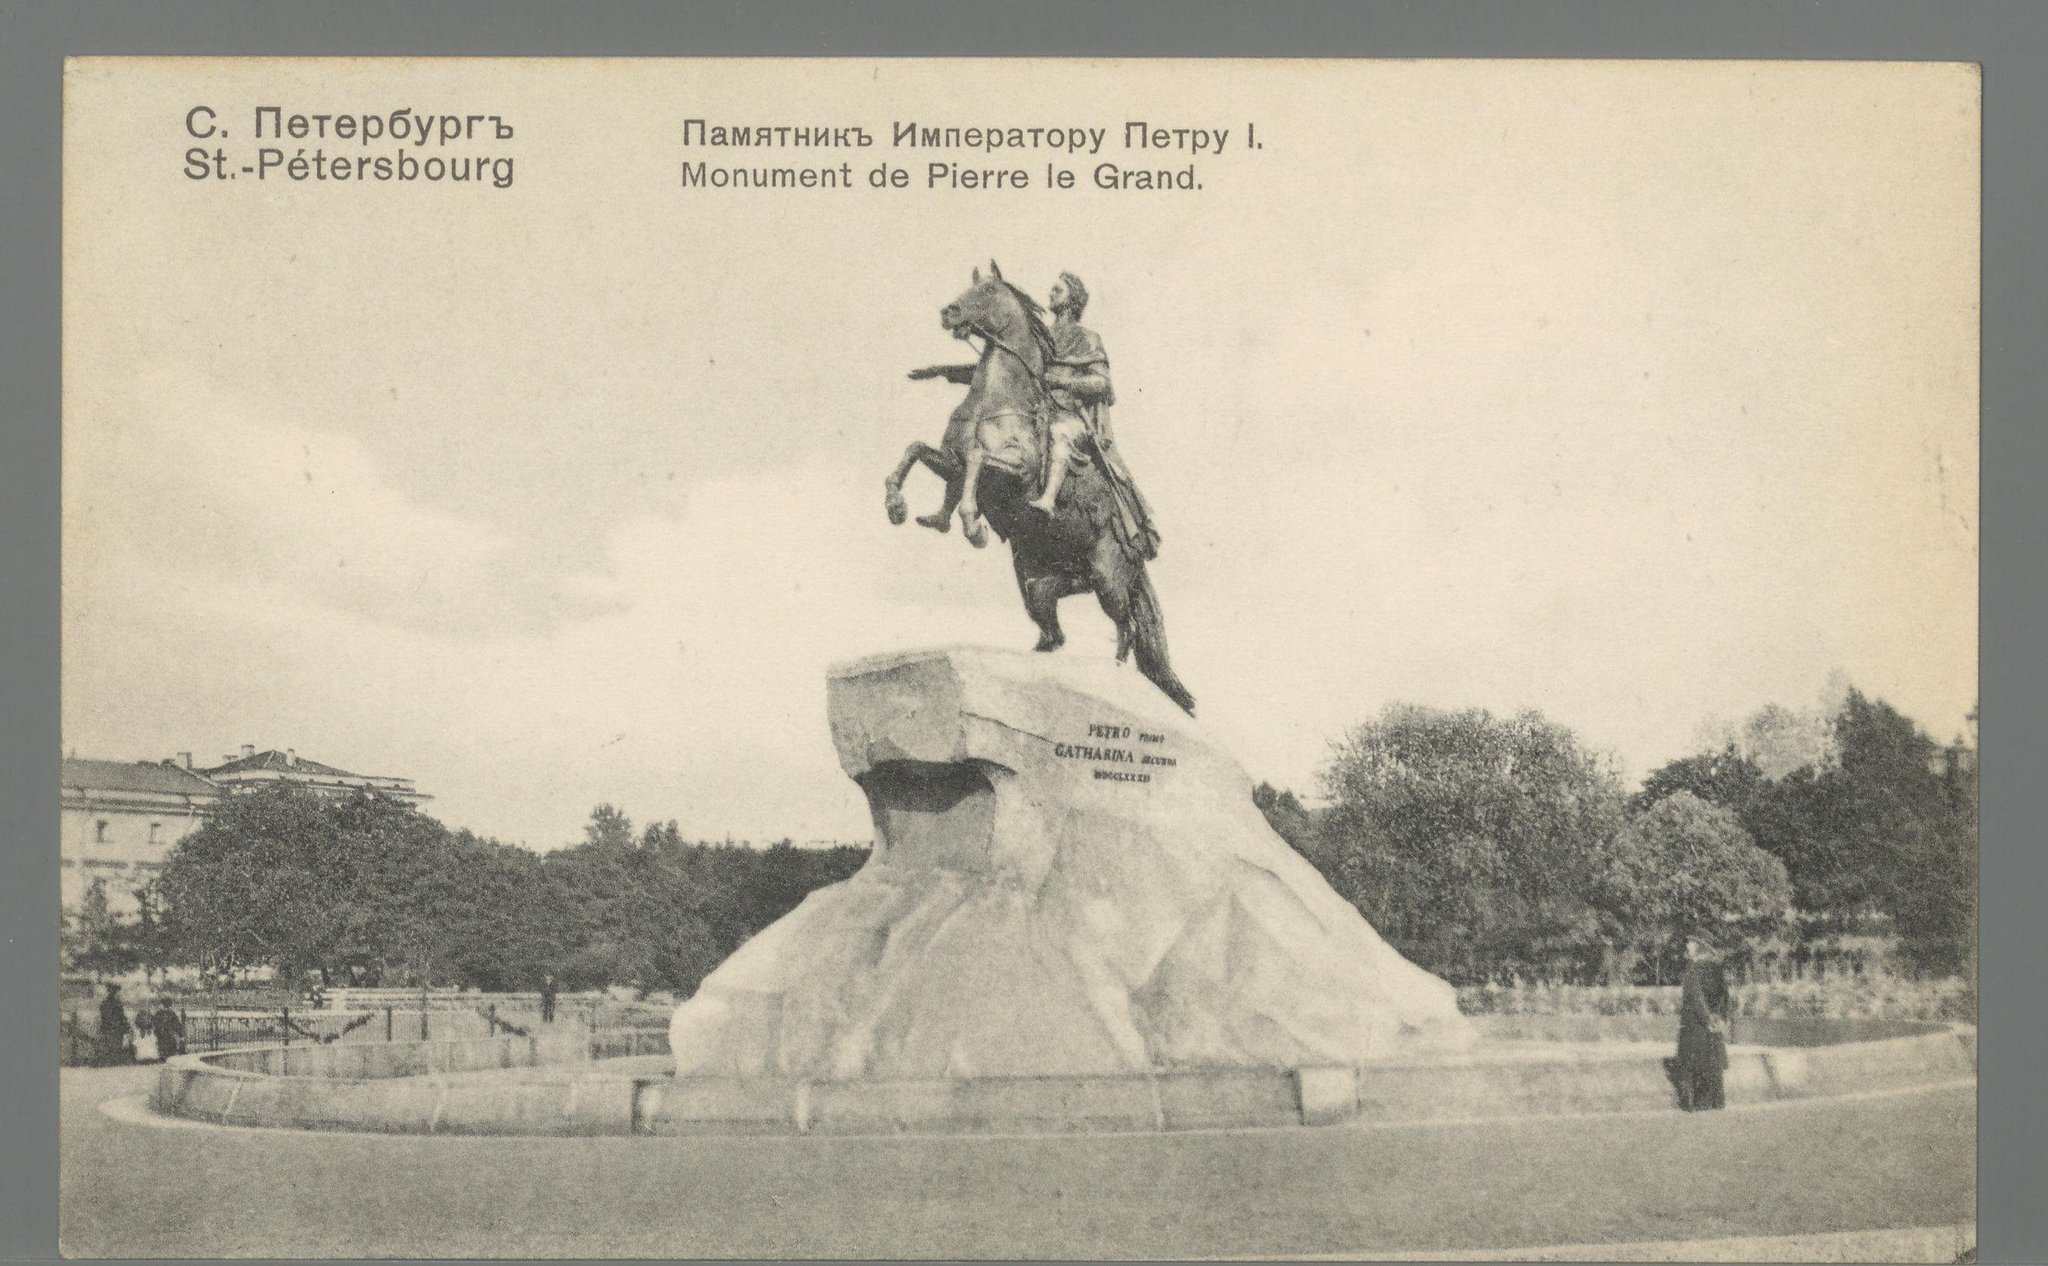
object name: photomechanical print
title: St.-Pétersbourg. Monument de Pierre le Grand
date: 1904-1930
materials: cardboard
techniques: photograph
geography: sint-petersburg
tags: peter i de grote (tsaar van rusland), emperor, monument, statue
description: Boven de Franse titel staat de titel in het Russisch.